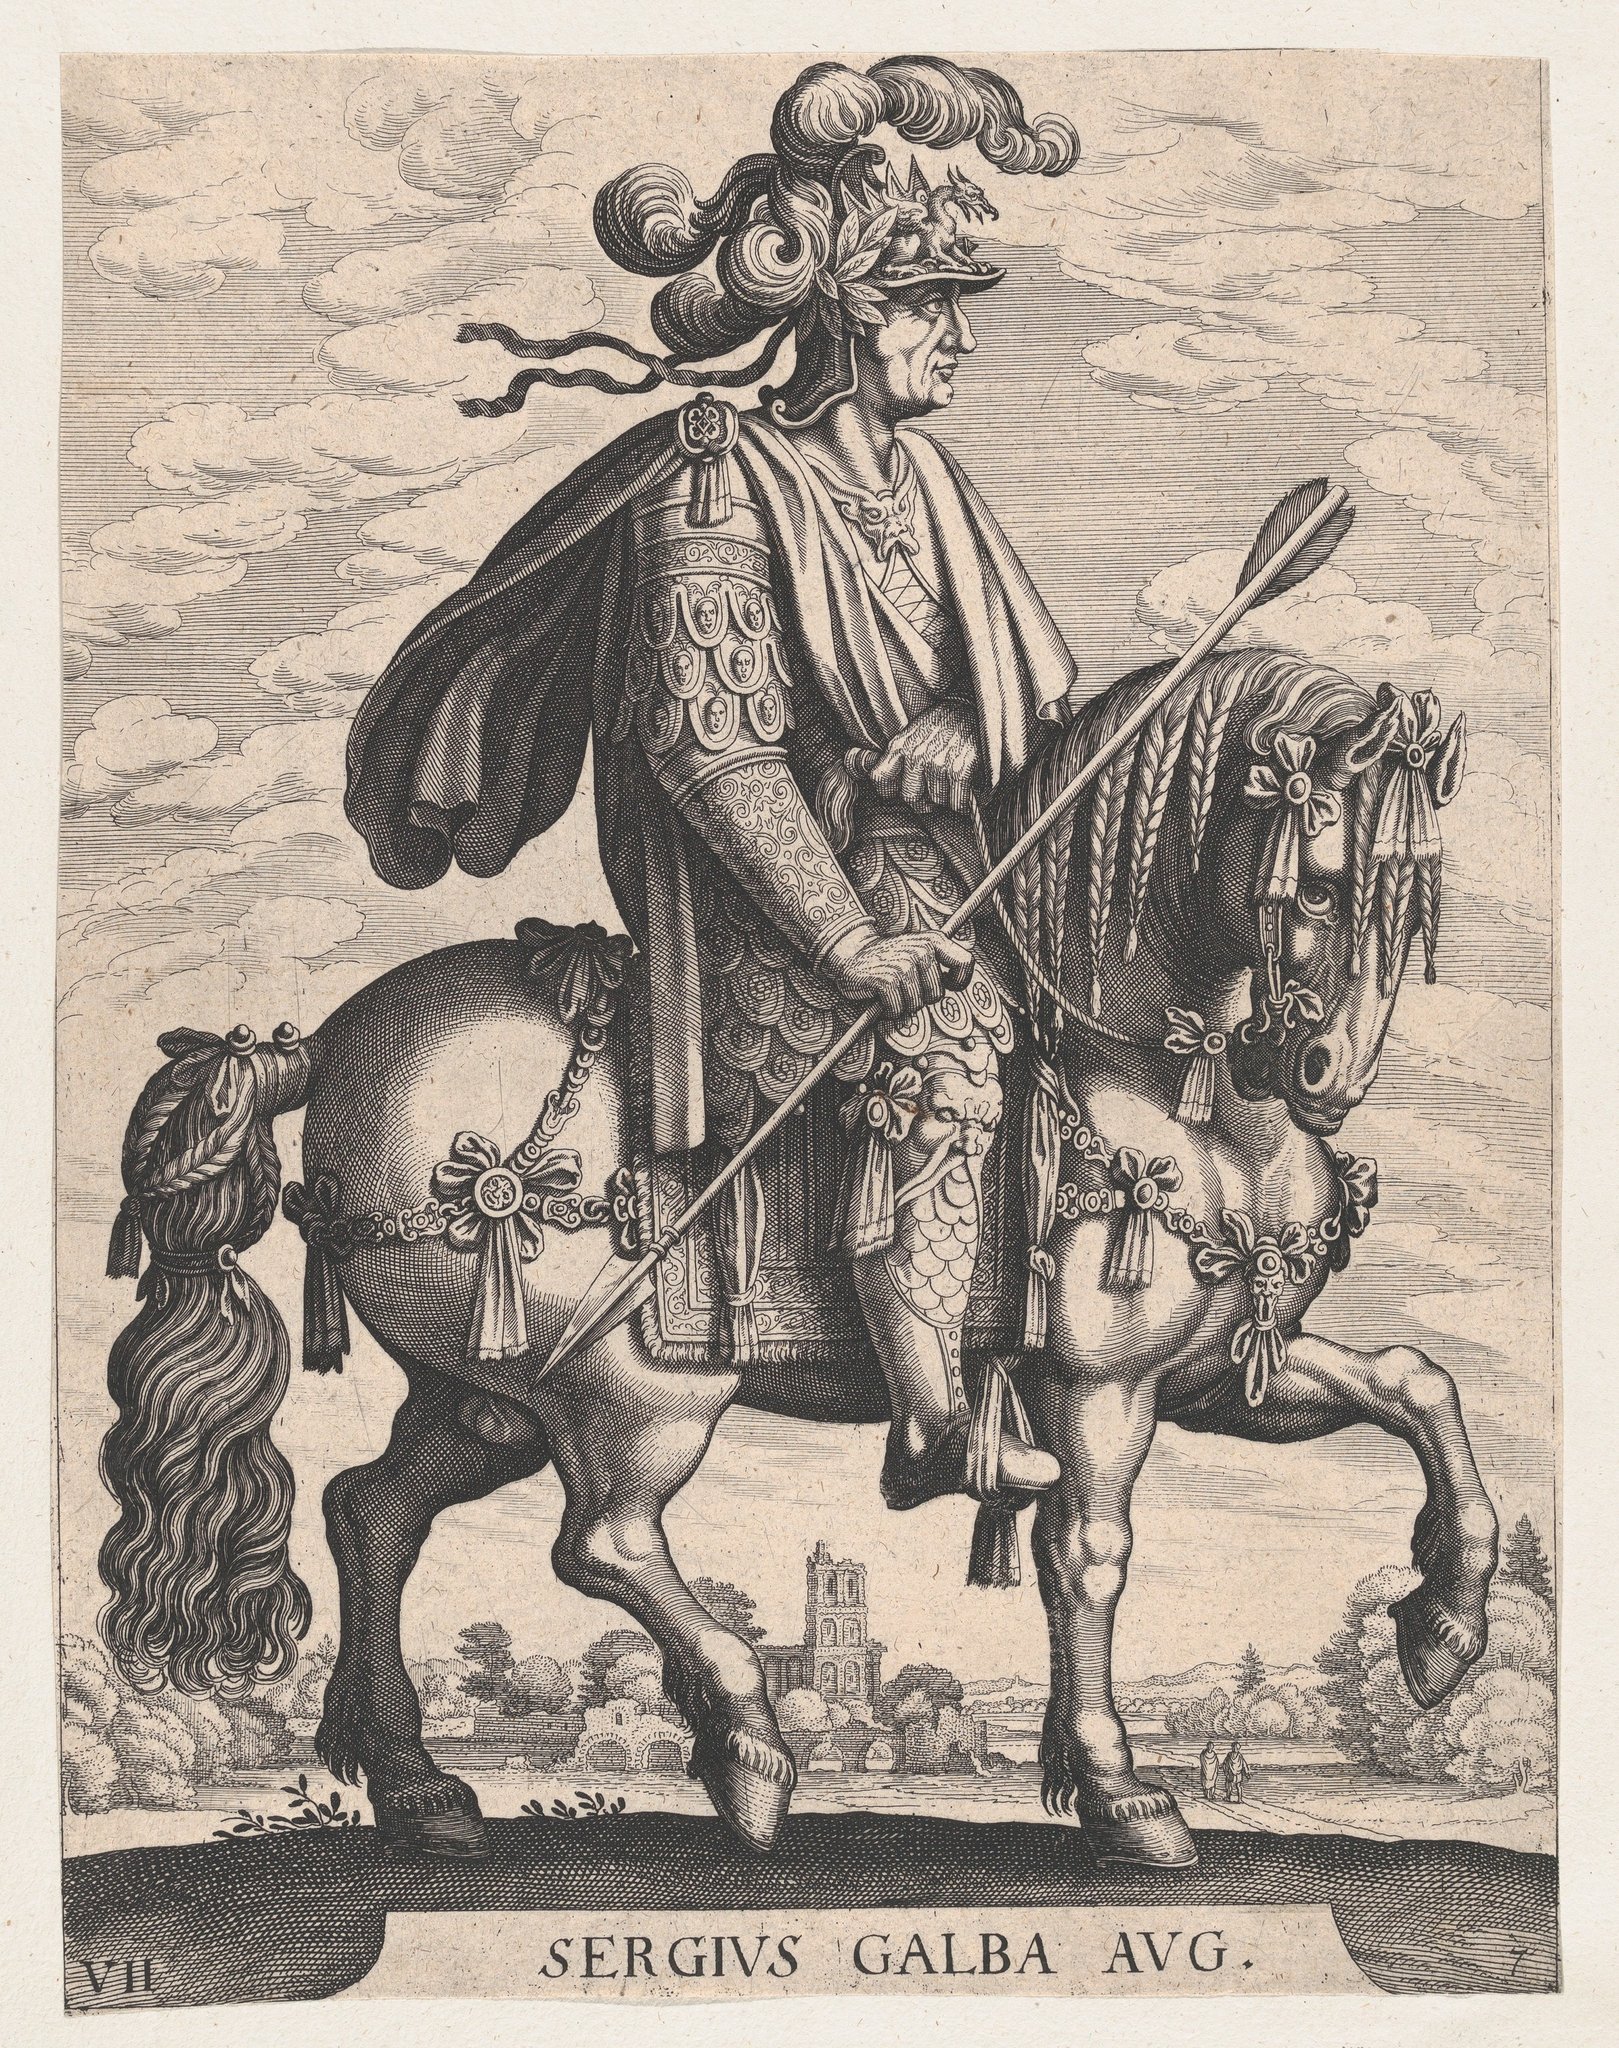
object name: print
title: Plate 7: Emperor Galba on Horseback, from 'The First Twelve Roman Caesars' after Tempesta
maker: matthäus merian the elder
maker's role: artist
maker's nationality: swiss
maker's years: 1593-1650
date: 1610-1650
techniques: engraving, etching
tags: spears,men,horses